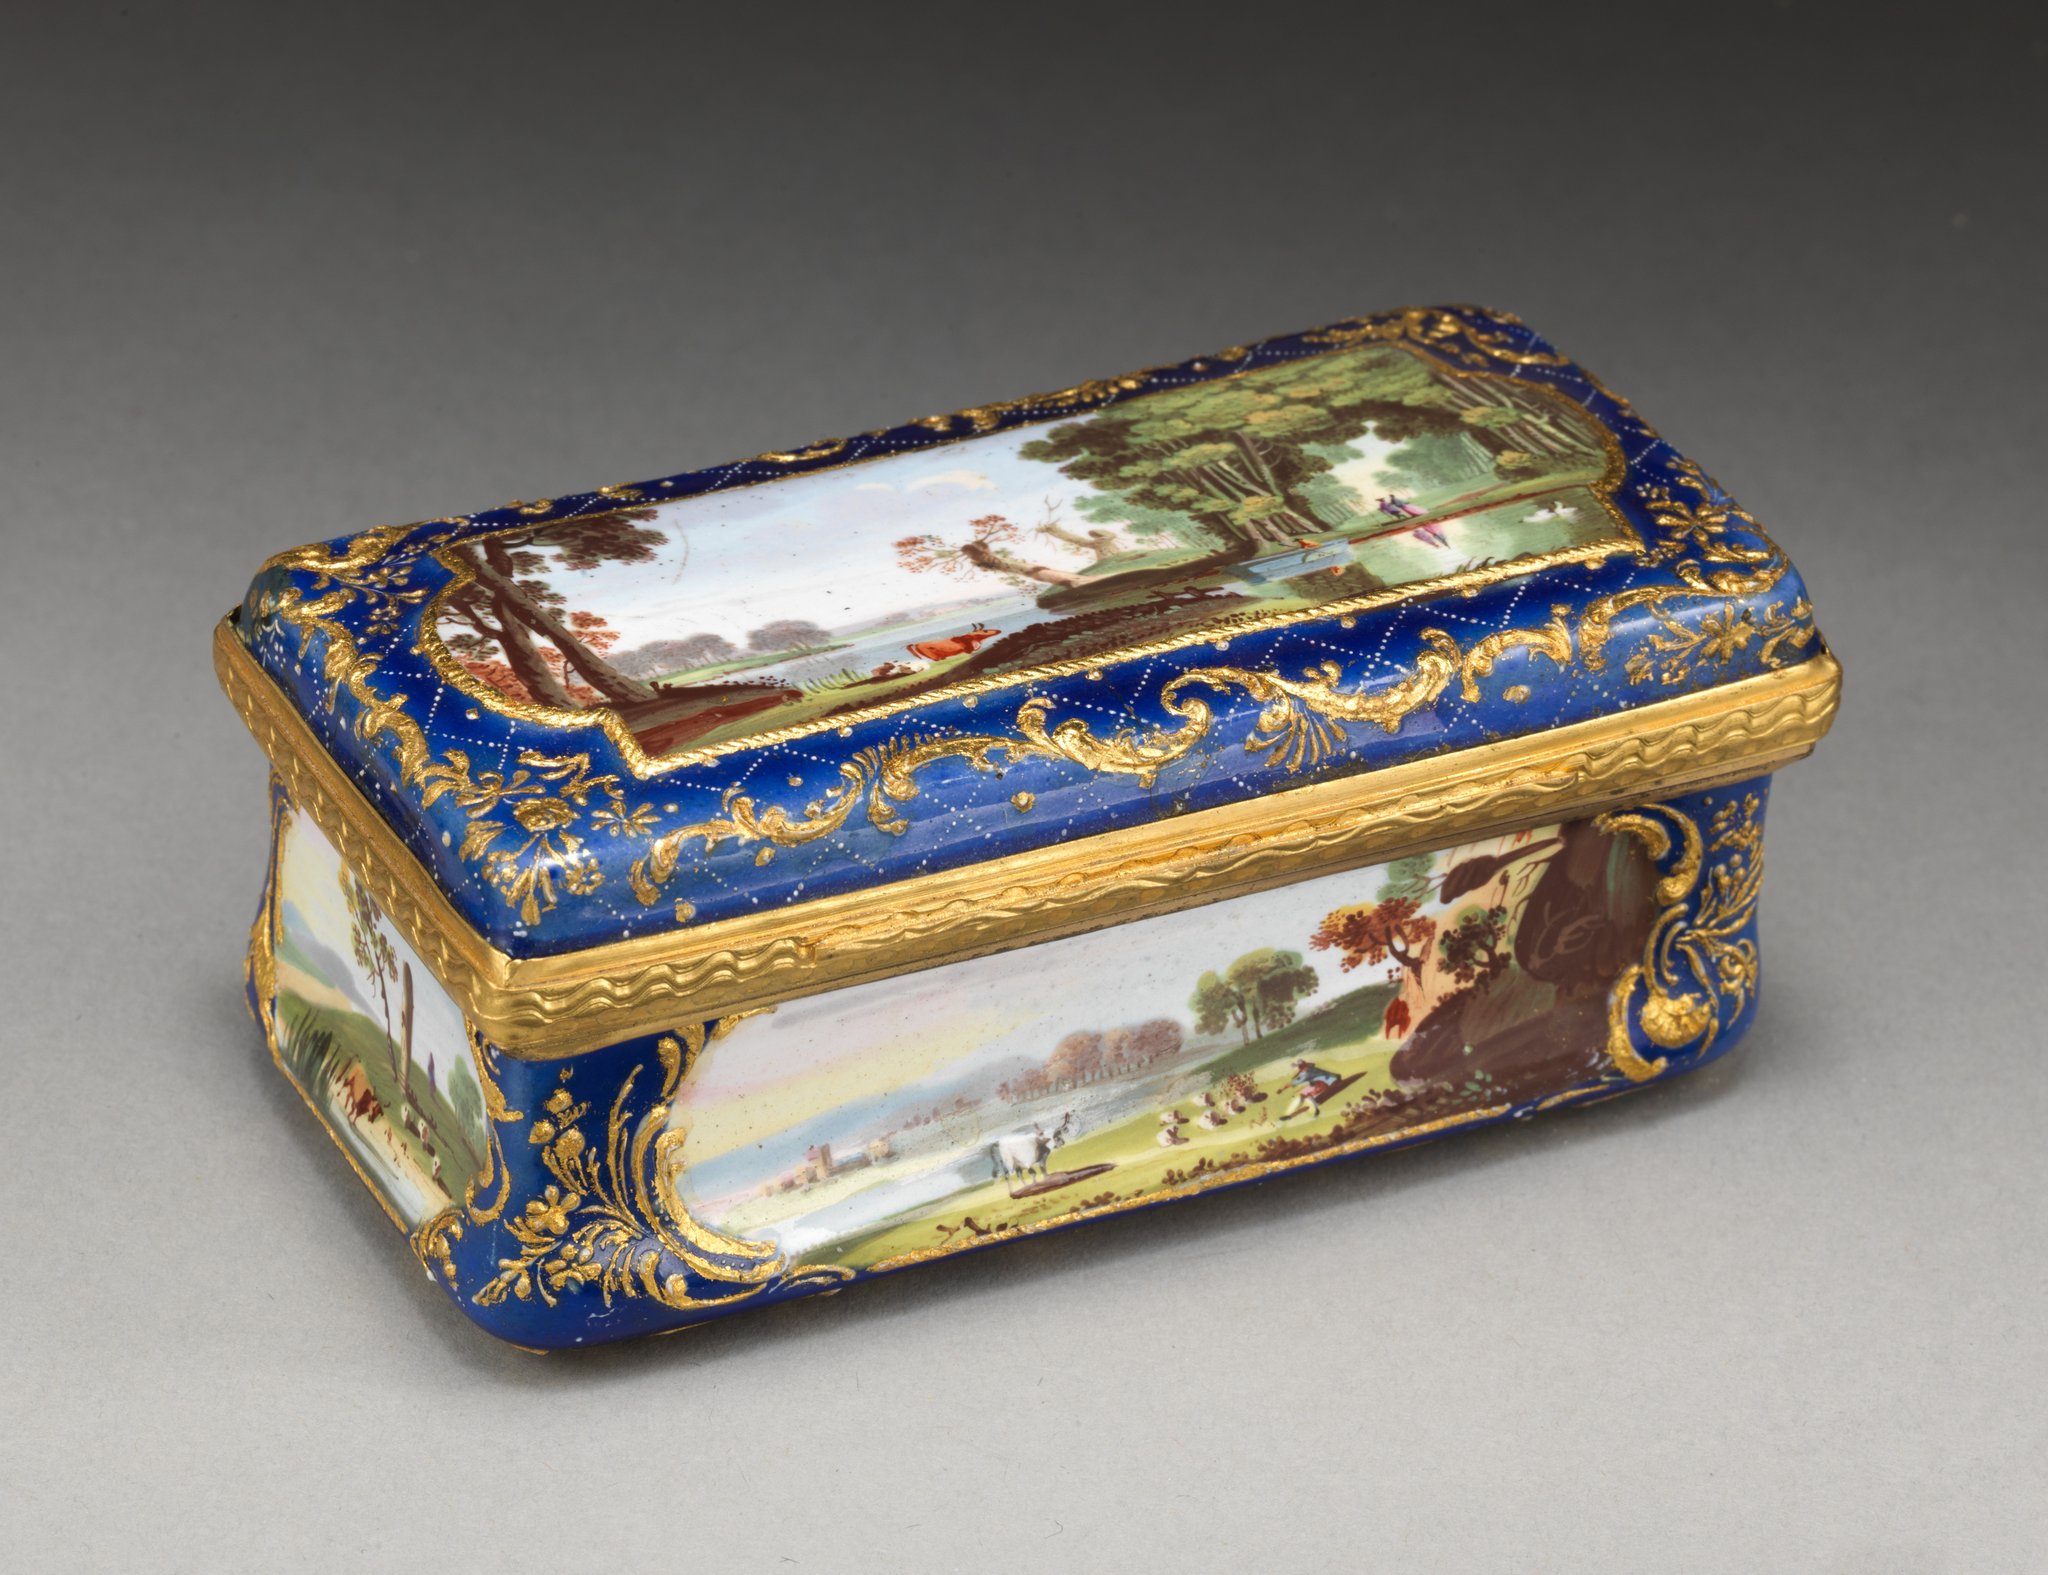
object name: snuffbox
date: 1770-1780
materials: copper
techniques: enamel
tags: animals,landscapes